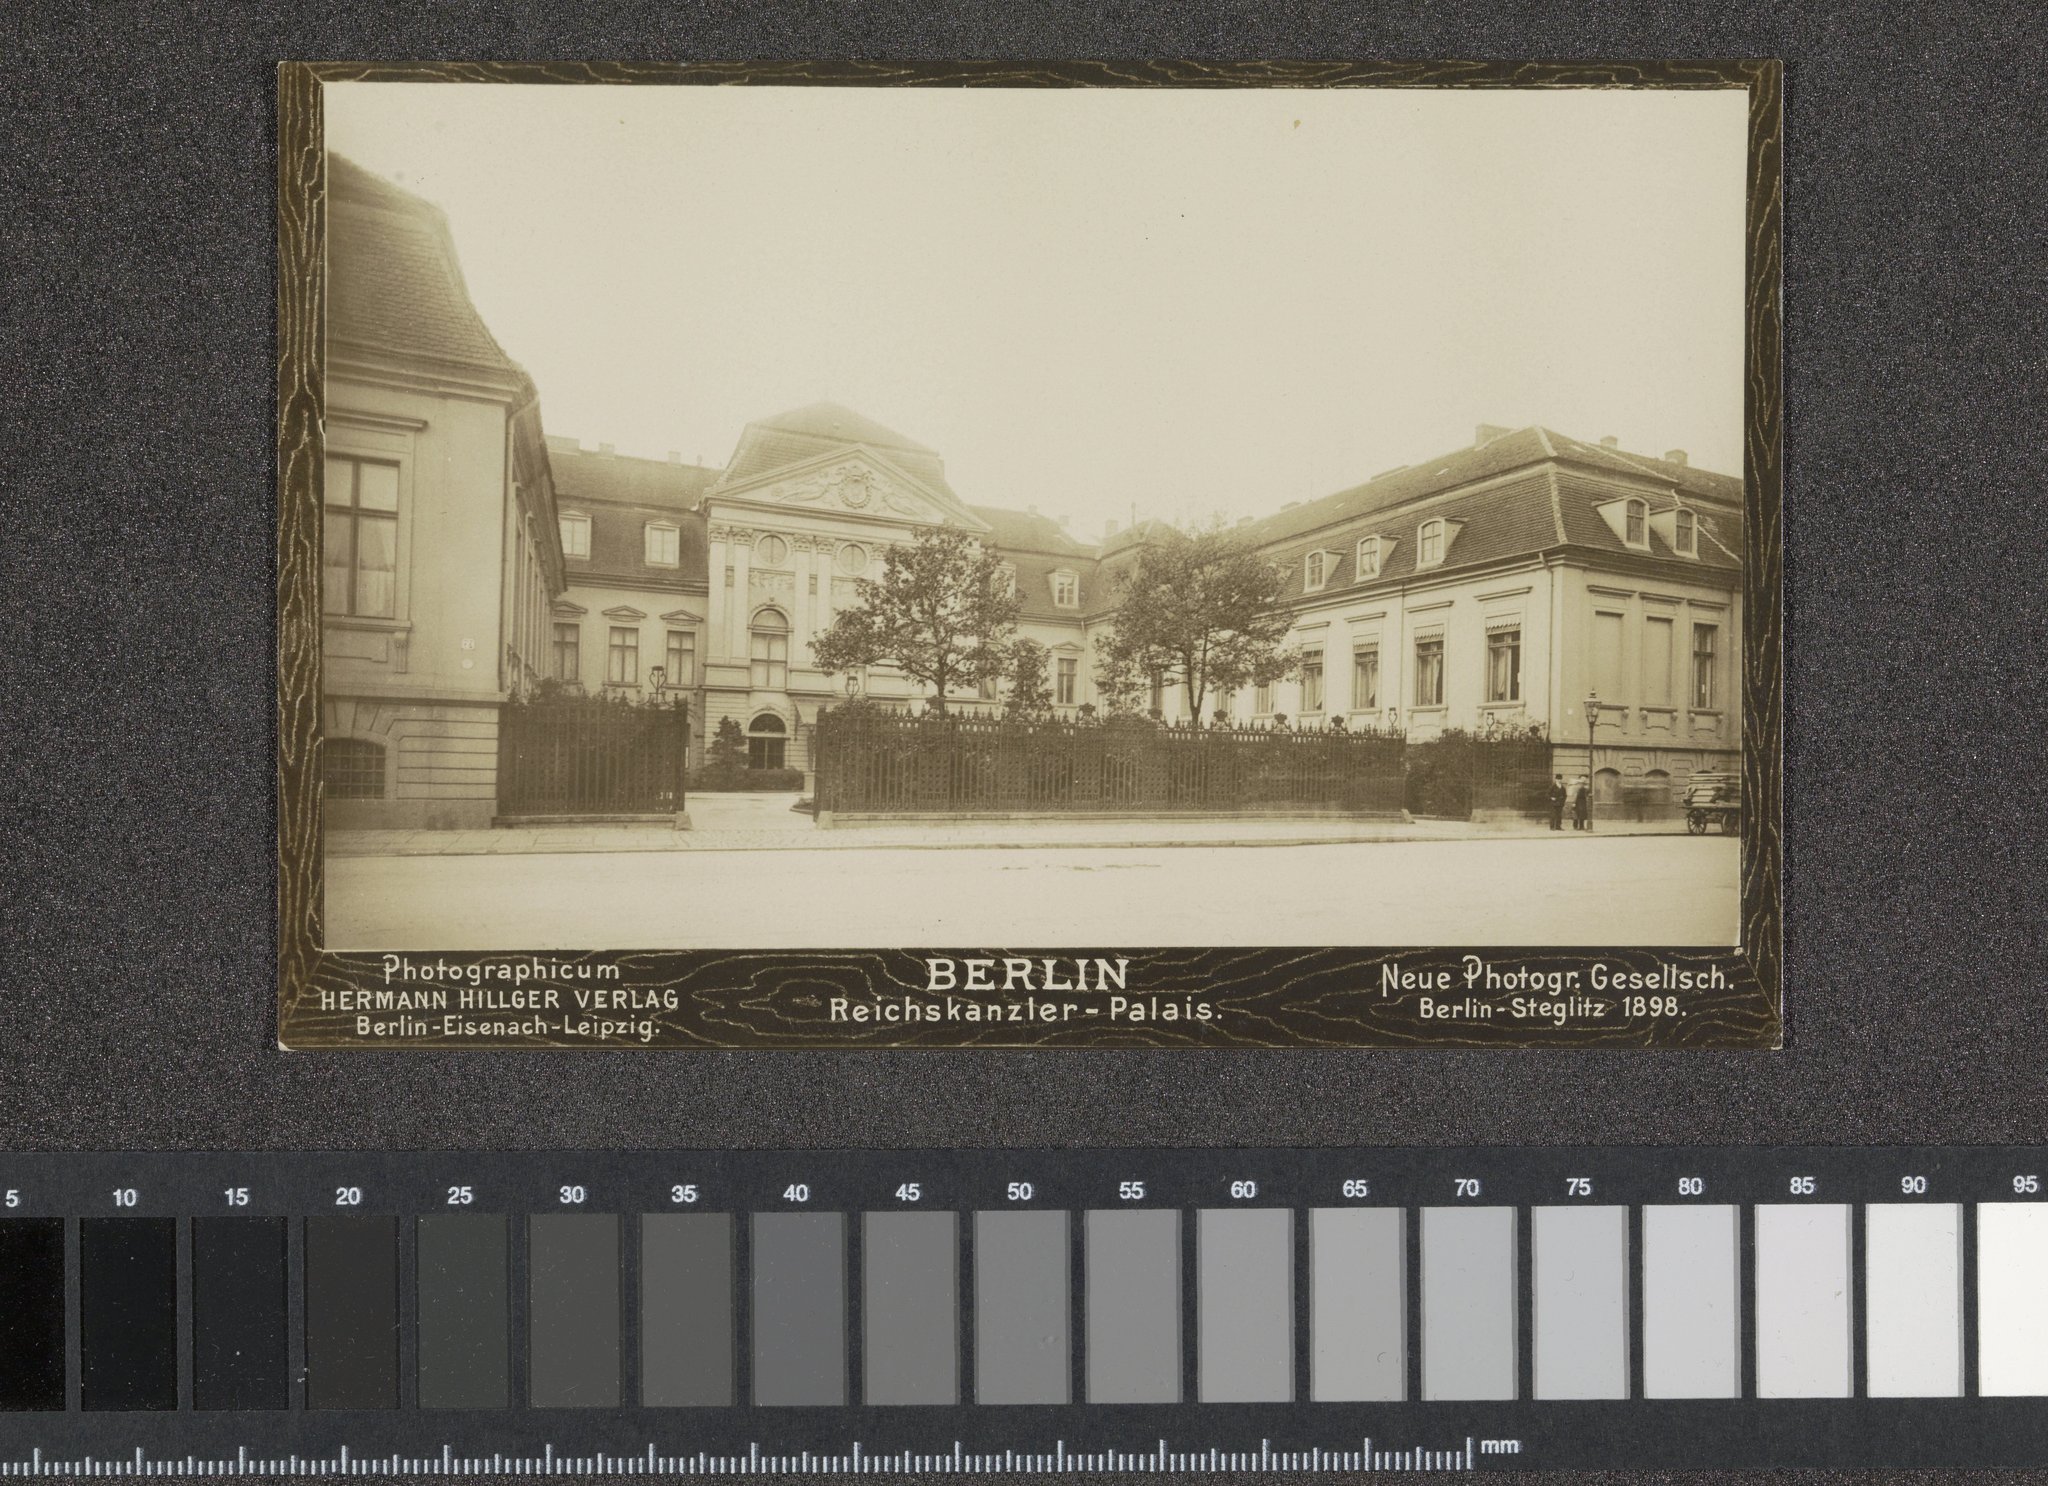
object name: ansichtkaart, prentbriefkaart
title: Berlin Reichskanzler-Palais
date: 1878-1898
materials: photographic support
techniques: gelatin silver print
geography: germany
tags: travelling; tourism, façade (of house or building)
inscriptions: inscription: ‘Berlin-Steglitz 1898’, inscription: ‘Photographicum’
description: Foto hoort bij een serie van 28 losse prentbriefkaarten van Engeland, Noorwegen, Italië, Duitsland en Tirol (foto's RP-F-F00945-1 t/m RP-F-F00945-28).